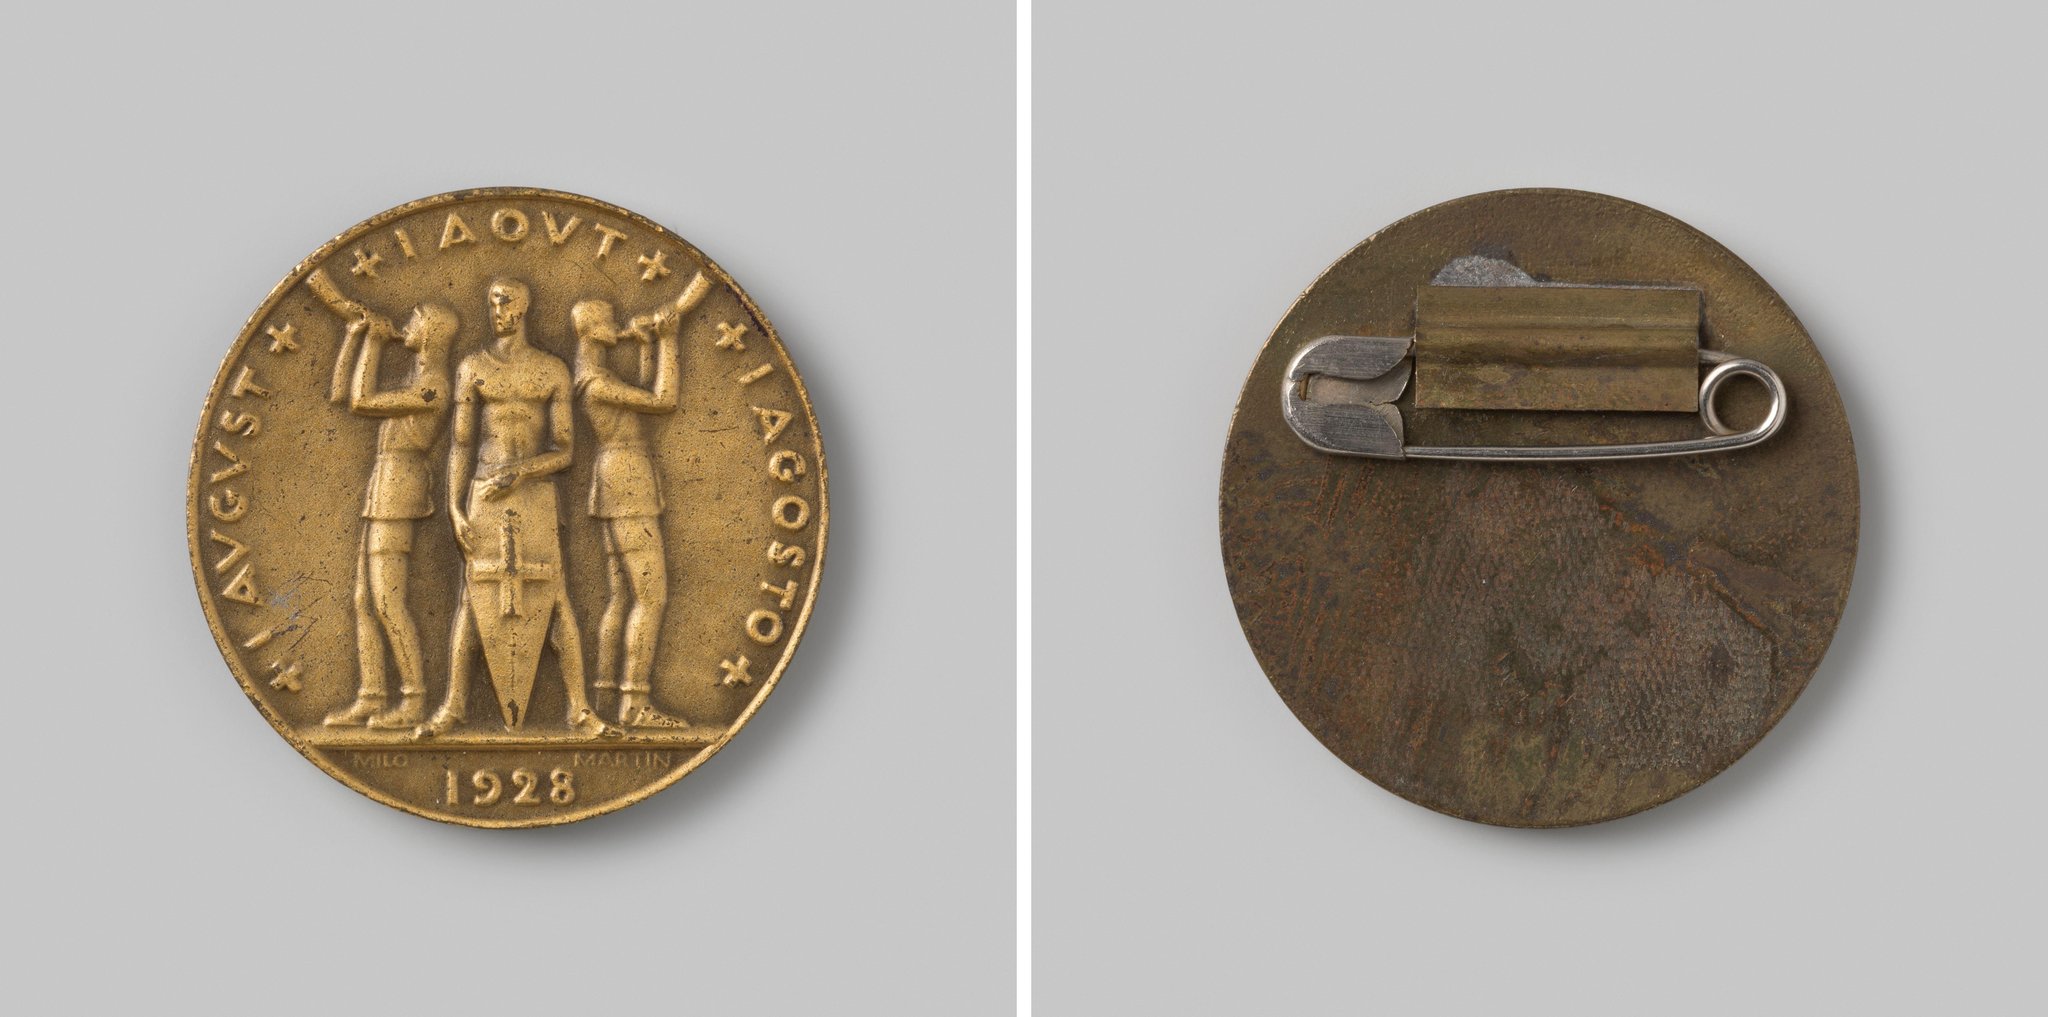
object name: history medal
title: 1 Augustus Zwitserse Nationale Feestdag 1928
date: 1928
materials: brass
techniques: striking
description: Ronde messing broche waarop drie staande mannen, twee met hoorns en de middelste met het Zwitserse wapenschild, met omschrift en afsnedetekst.